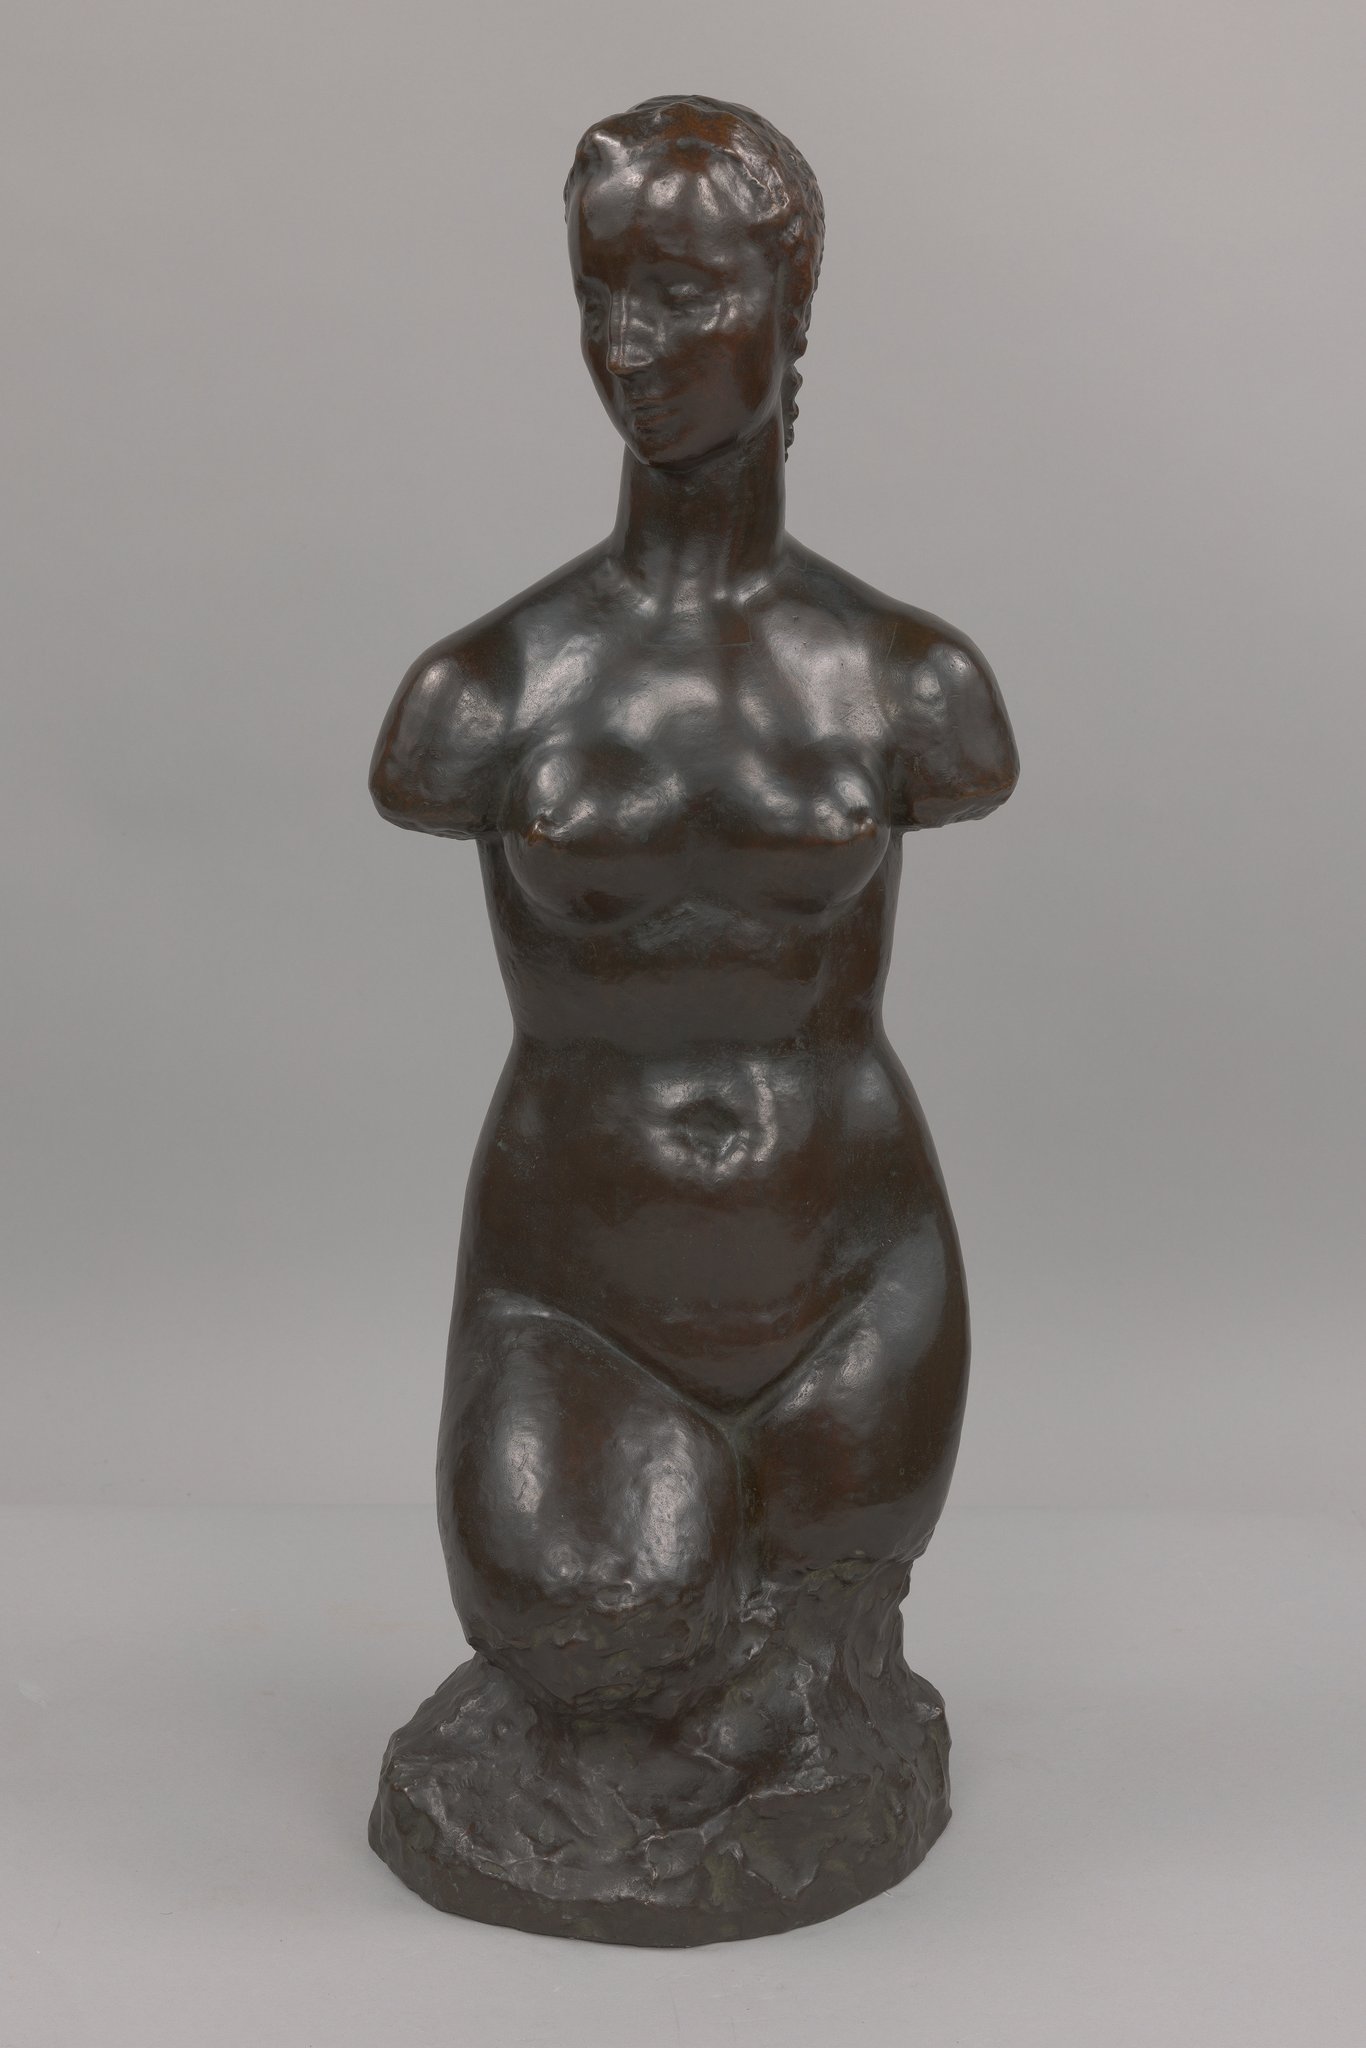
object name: sculpture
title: Small Female Torso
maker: wilhelm lehmbruck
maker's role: artist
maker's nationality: german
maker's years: 1881-1919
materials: bronze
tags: female nudes